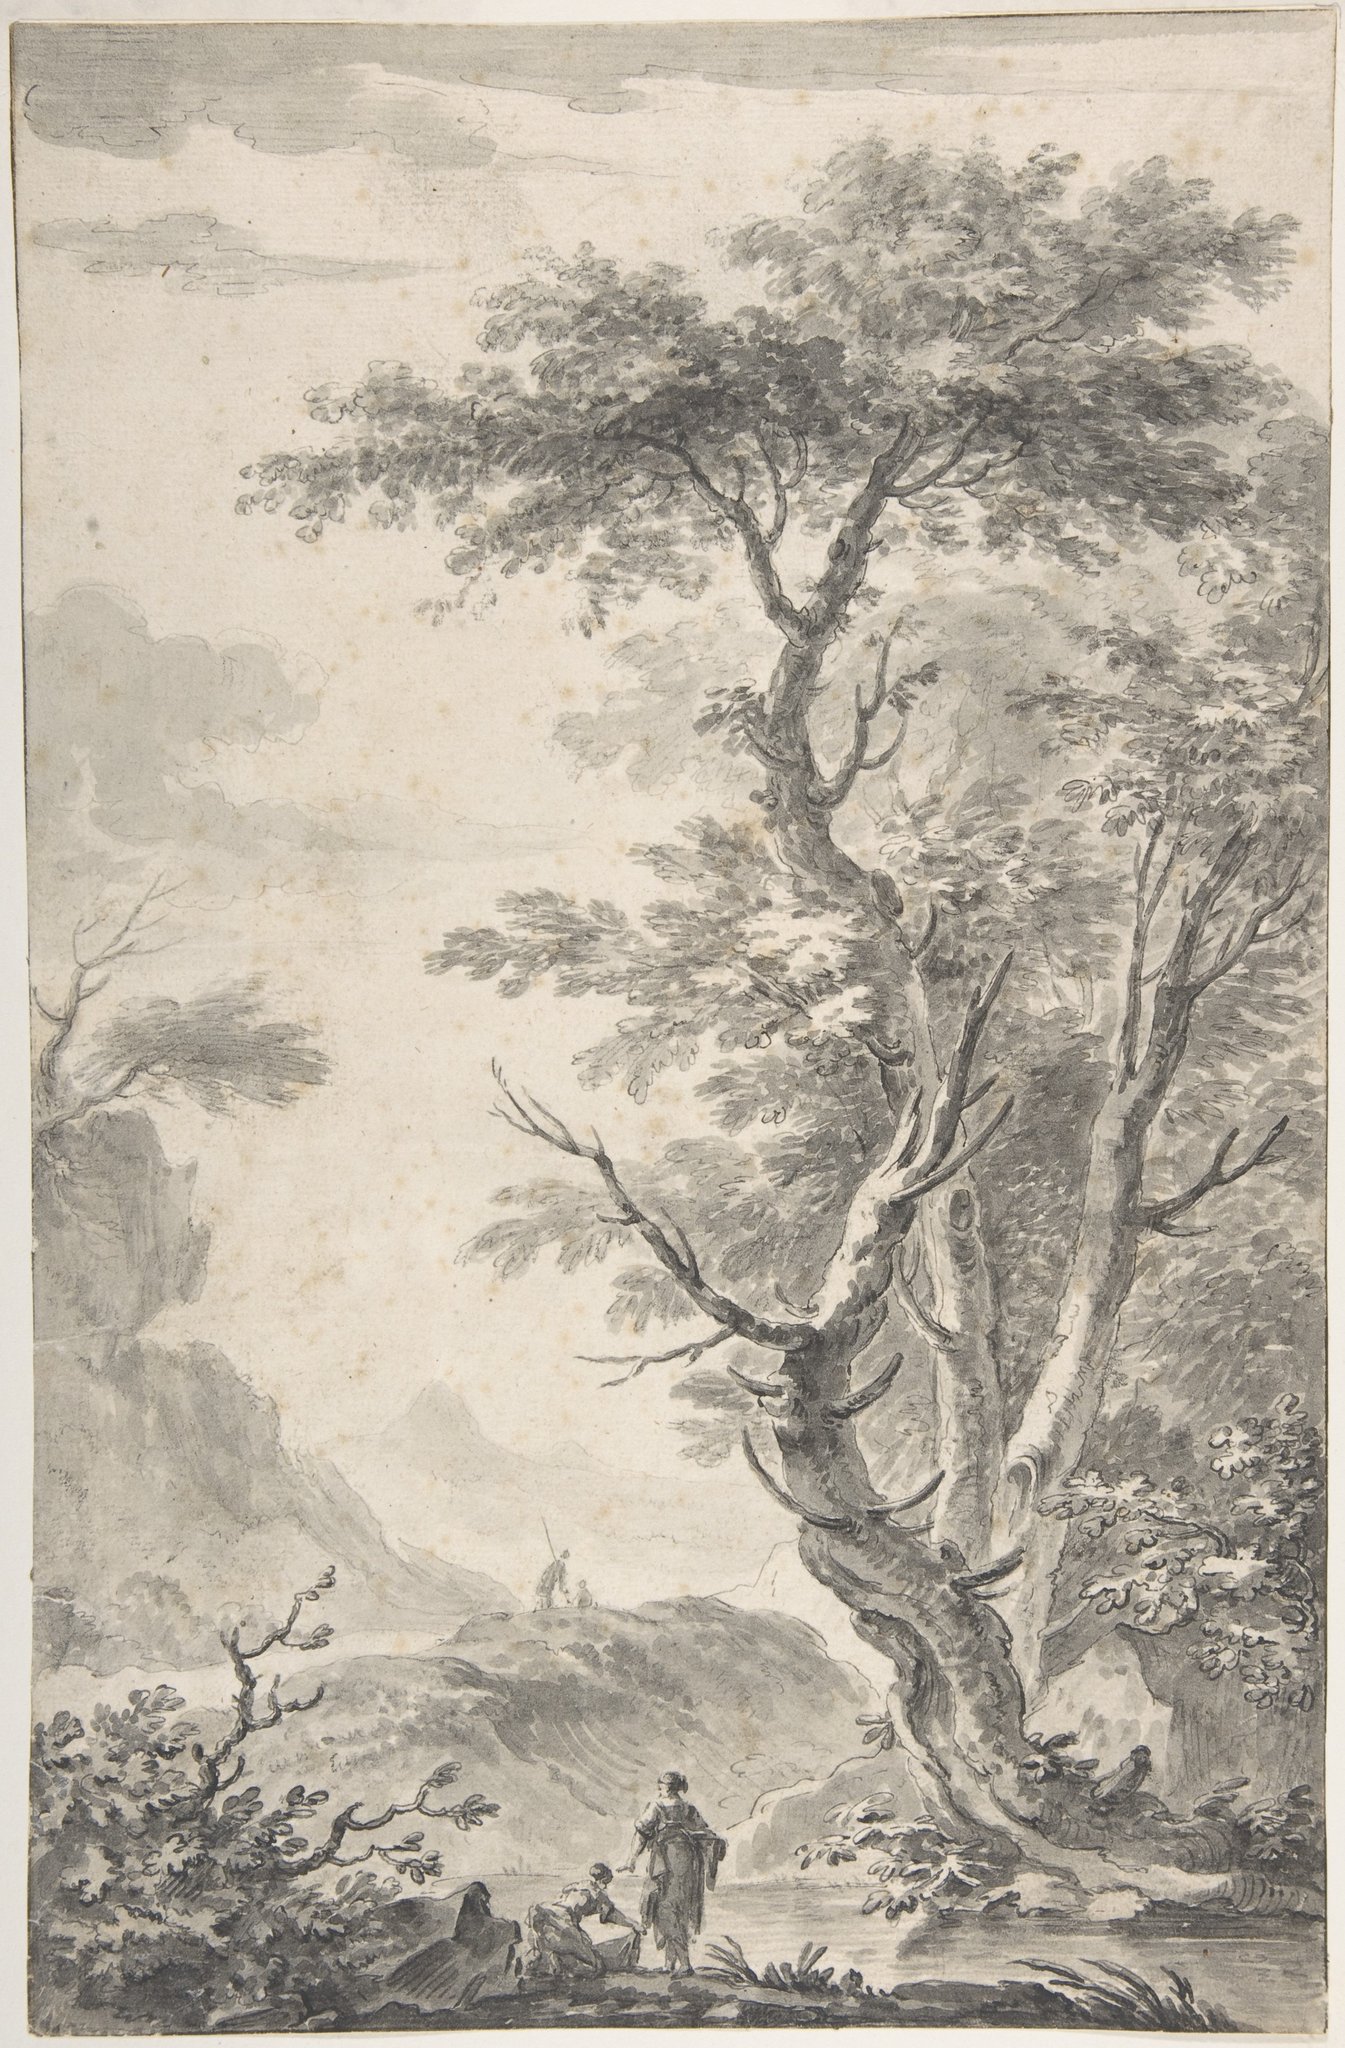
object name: drawing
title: Washerwoman by a Brook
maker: jean pillement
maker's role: artist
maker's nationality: french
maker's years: 1728-1808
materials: chalk, ink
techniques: brush, pen, wash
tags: women,rivers,trees